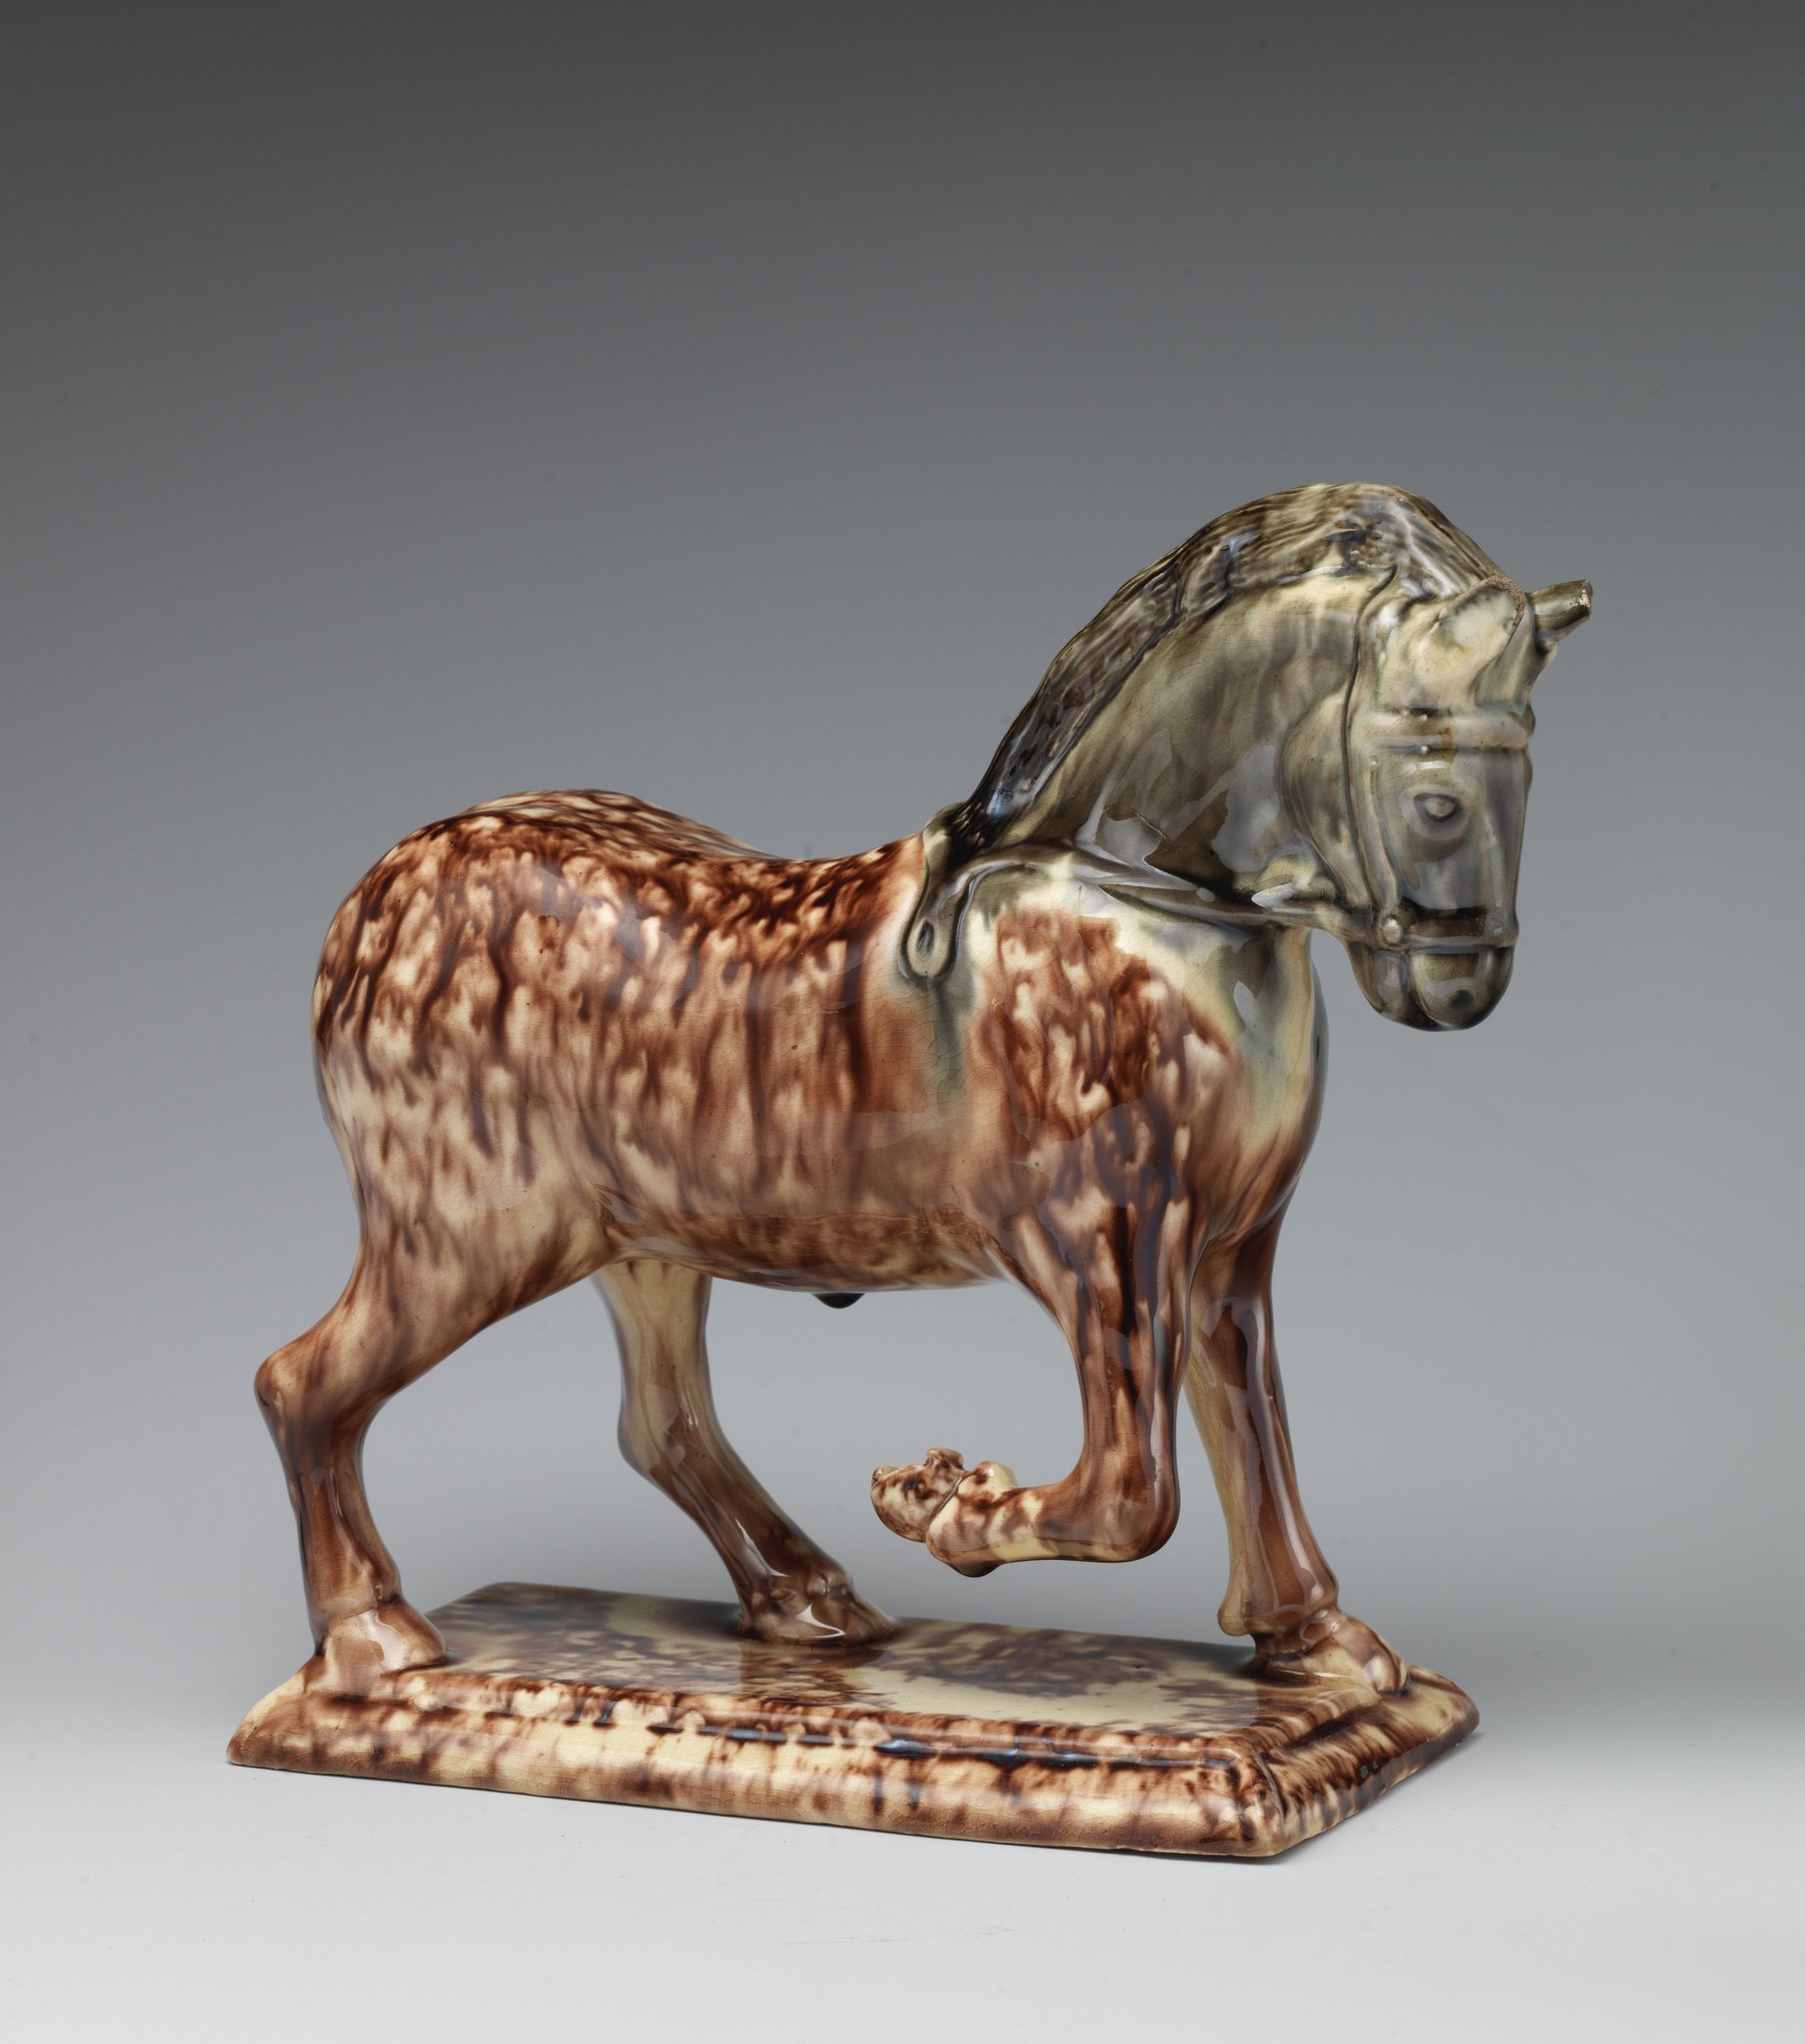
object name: figure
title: Horse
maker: whieldon type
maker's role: maker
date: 1750-1760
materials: earthenware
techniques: glazing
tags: horses